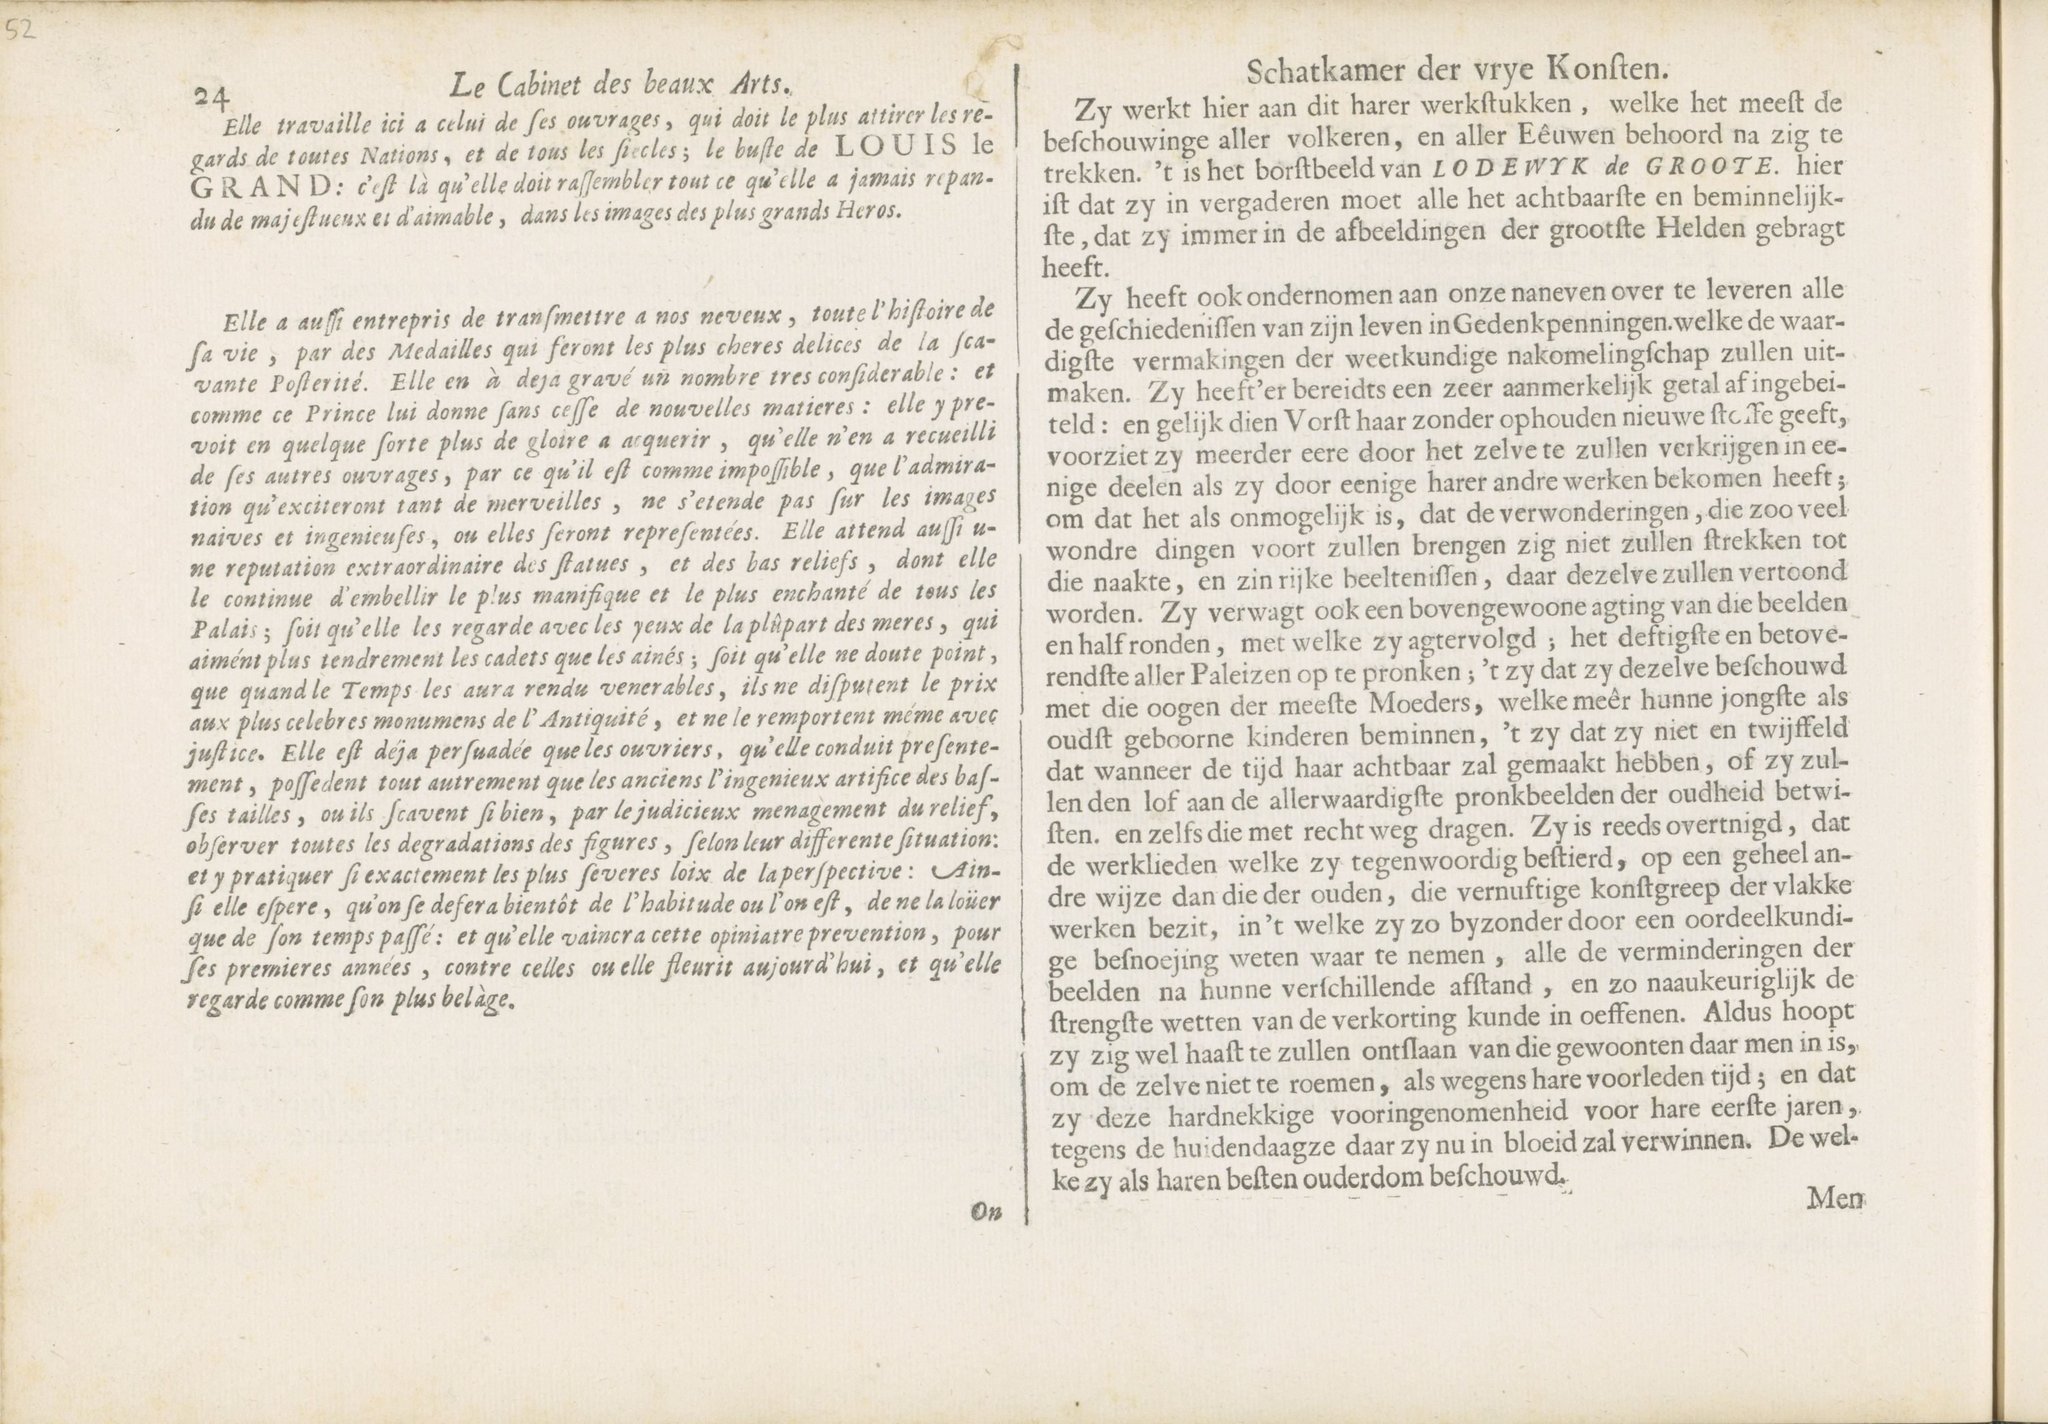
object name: text sheet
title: Tekstblad over de Beeldhouwkunst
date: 1693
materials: paper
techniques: letterpress printing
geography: amsterdam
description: Verklaring van de prent met de voorstelling van de personificatie van Beeldhouwkunst in het Frans en het Nederlands, pagina 24. Tekstblad maakt deel uit van een album.